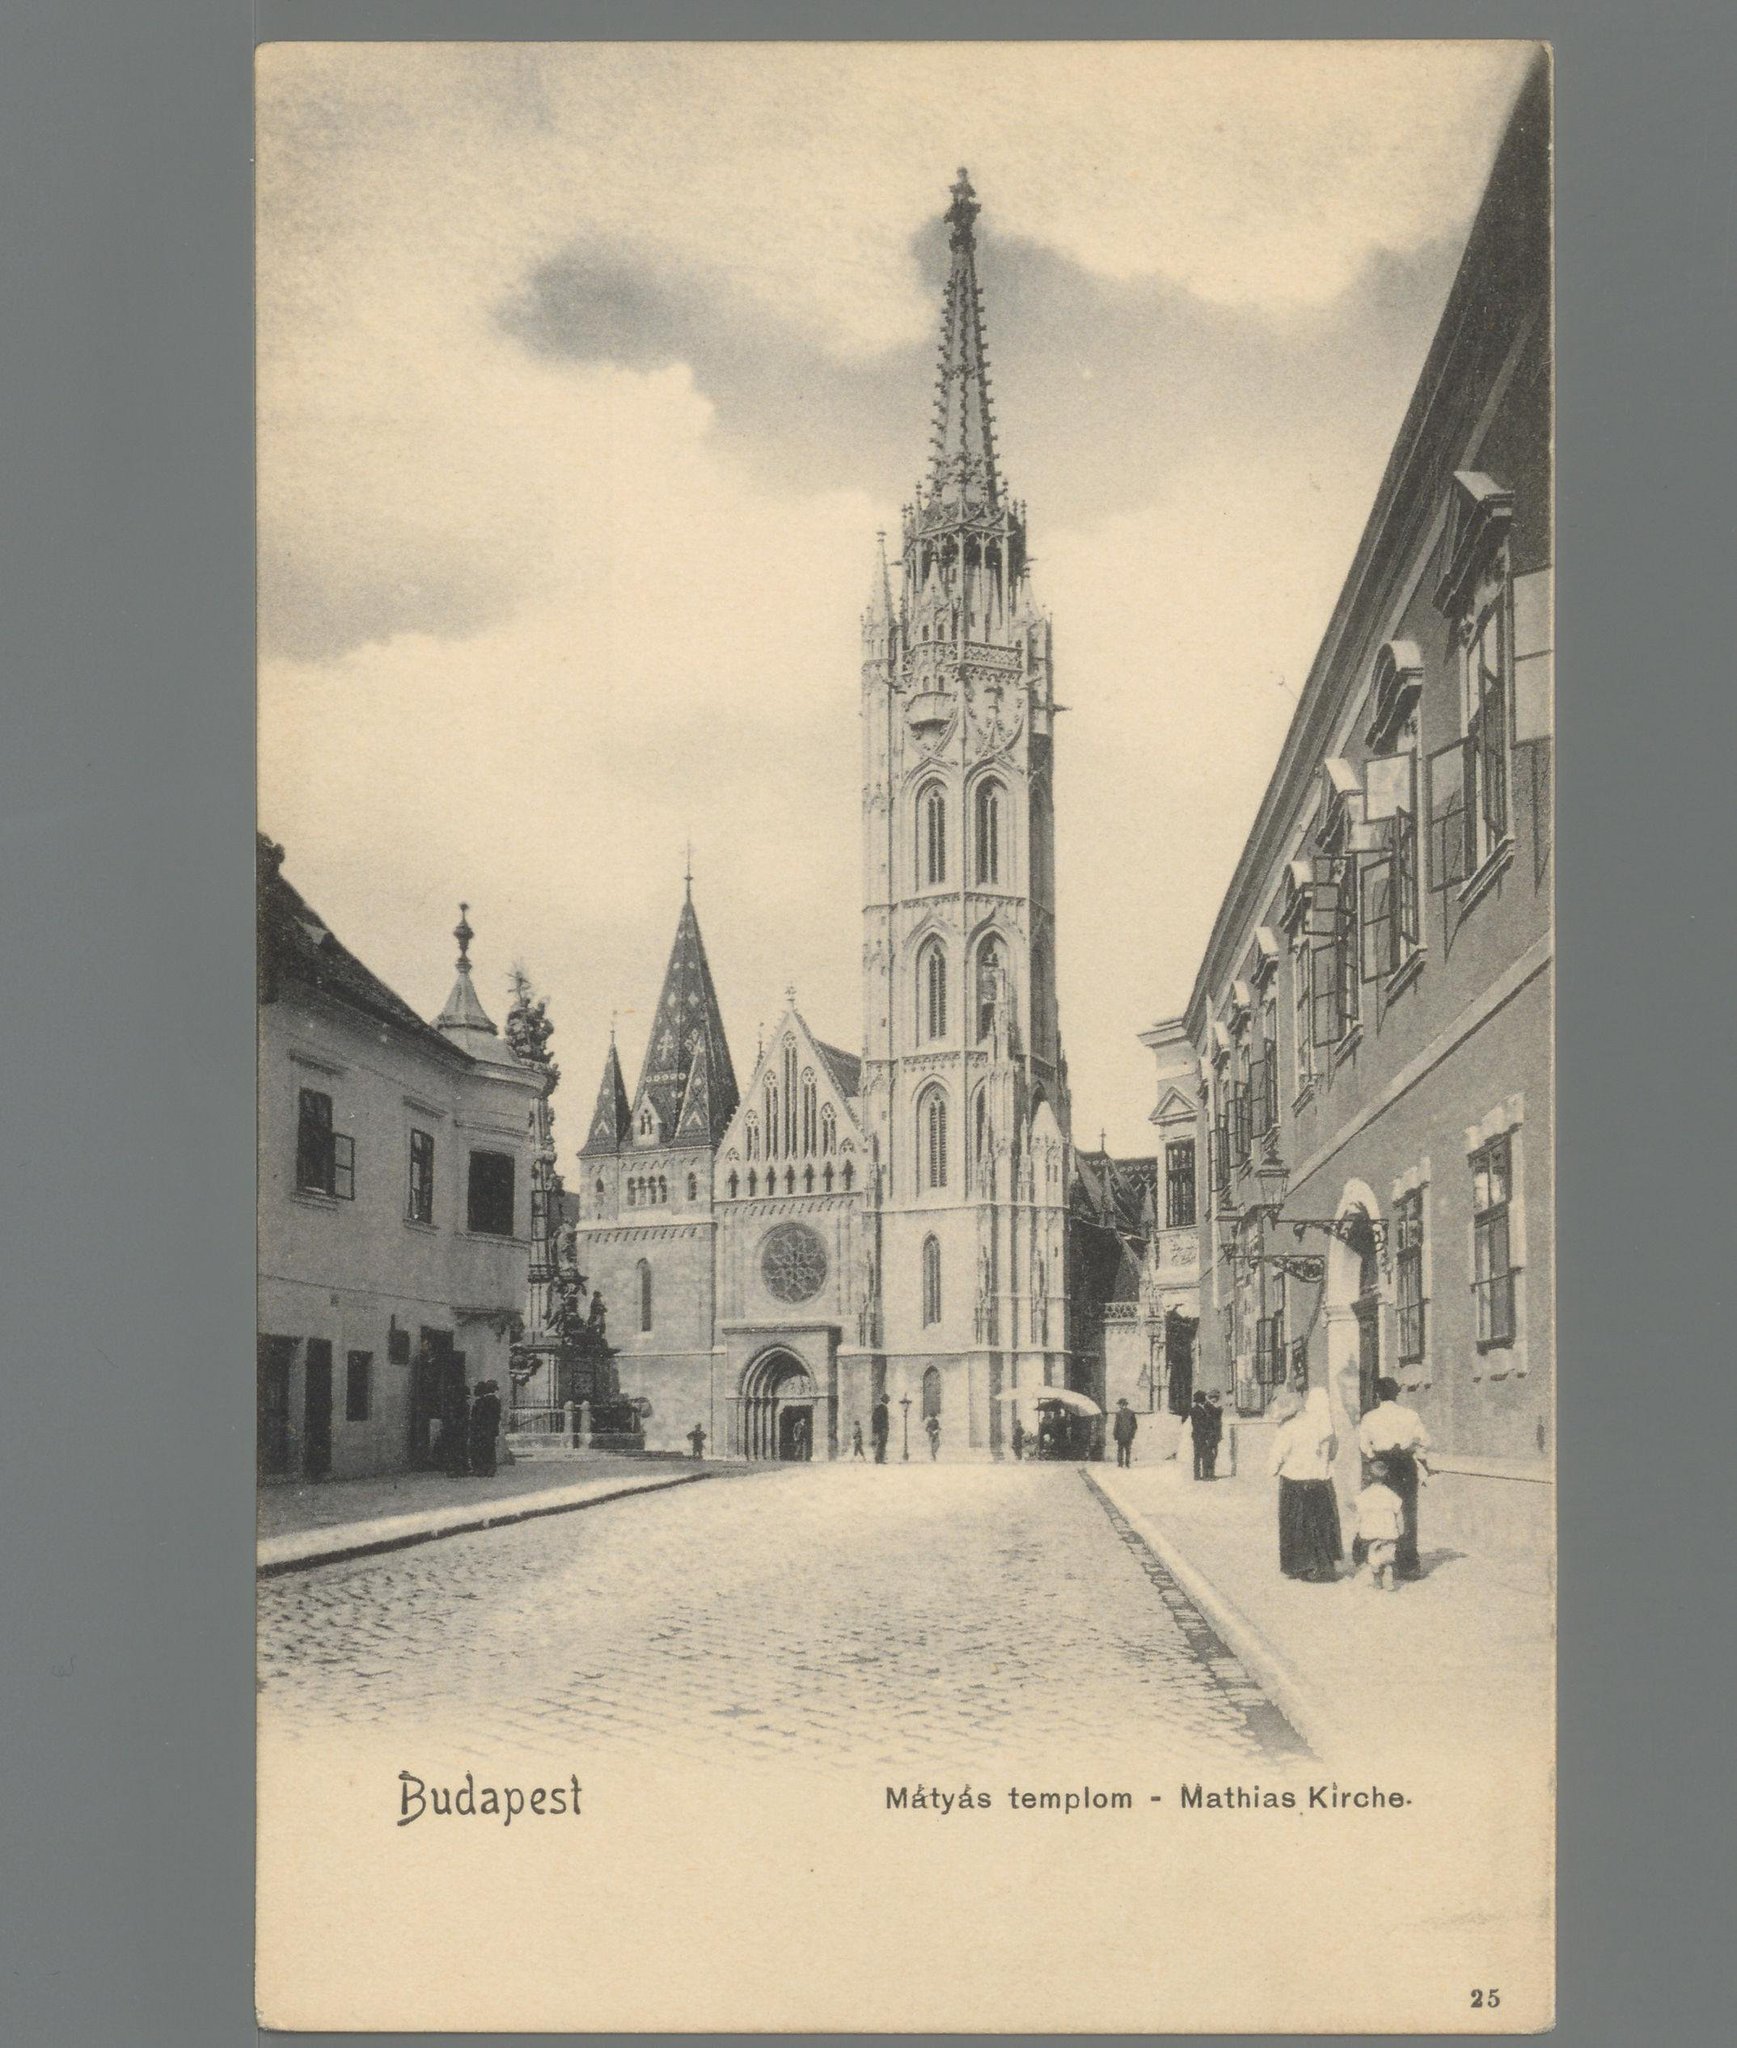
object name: ansichtkaart, prentbriefkaart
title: Budapest. Mátyás templom / Mathias Kirche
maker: Anonymous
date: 1905-1930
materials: cardboard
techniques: photograph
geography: budapest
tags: church (exterior)